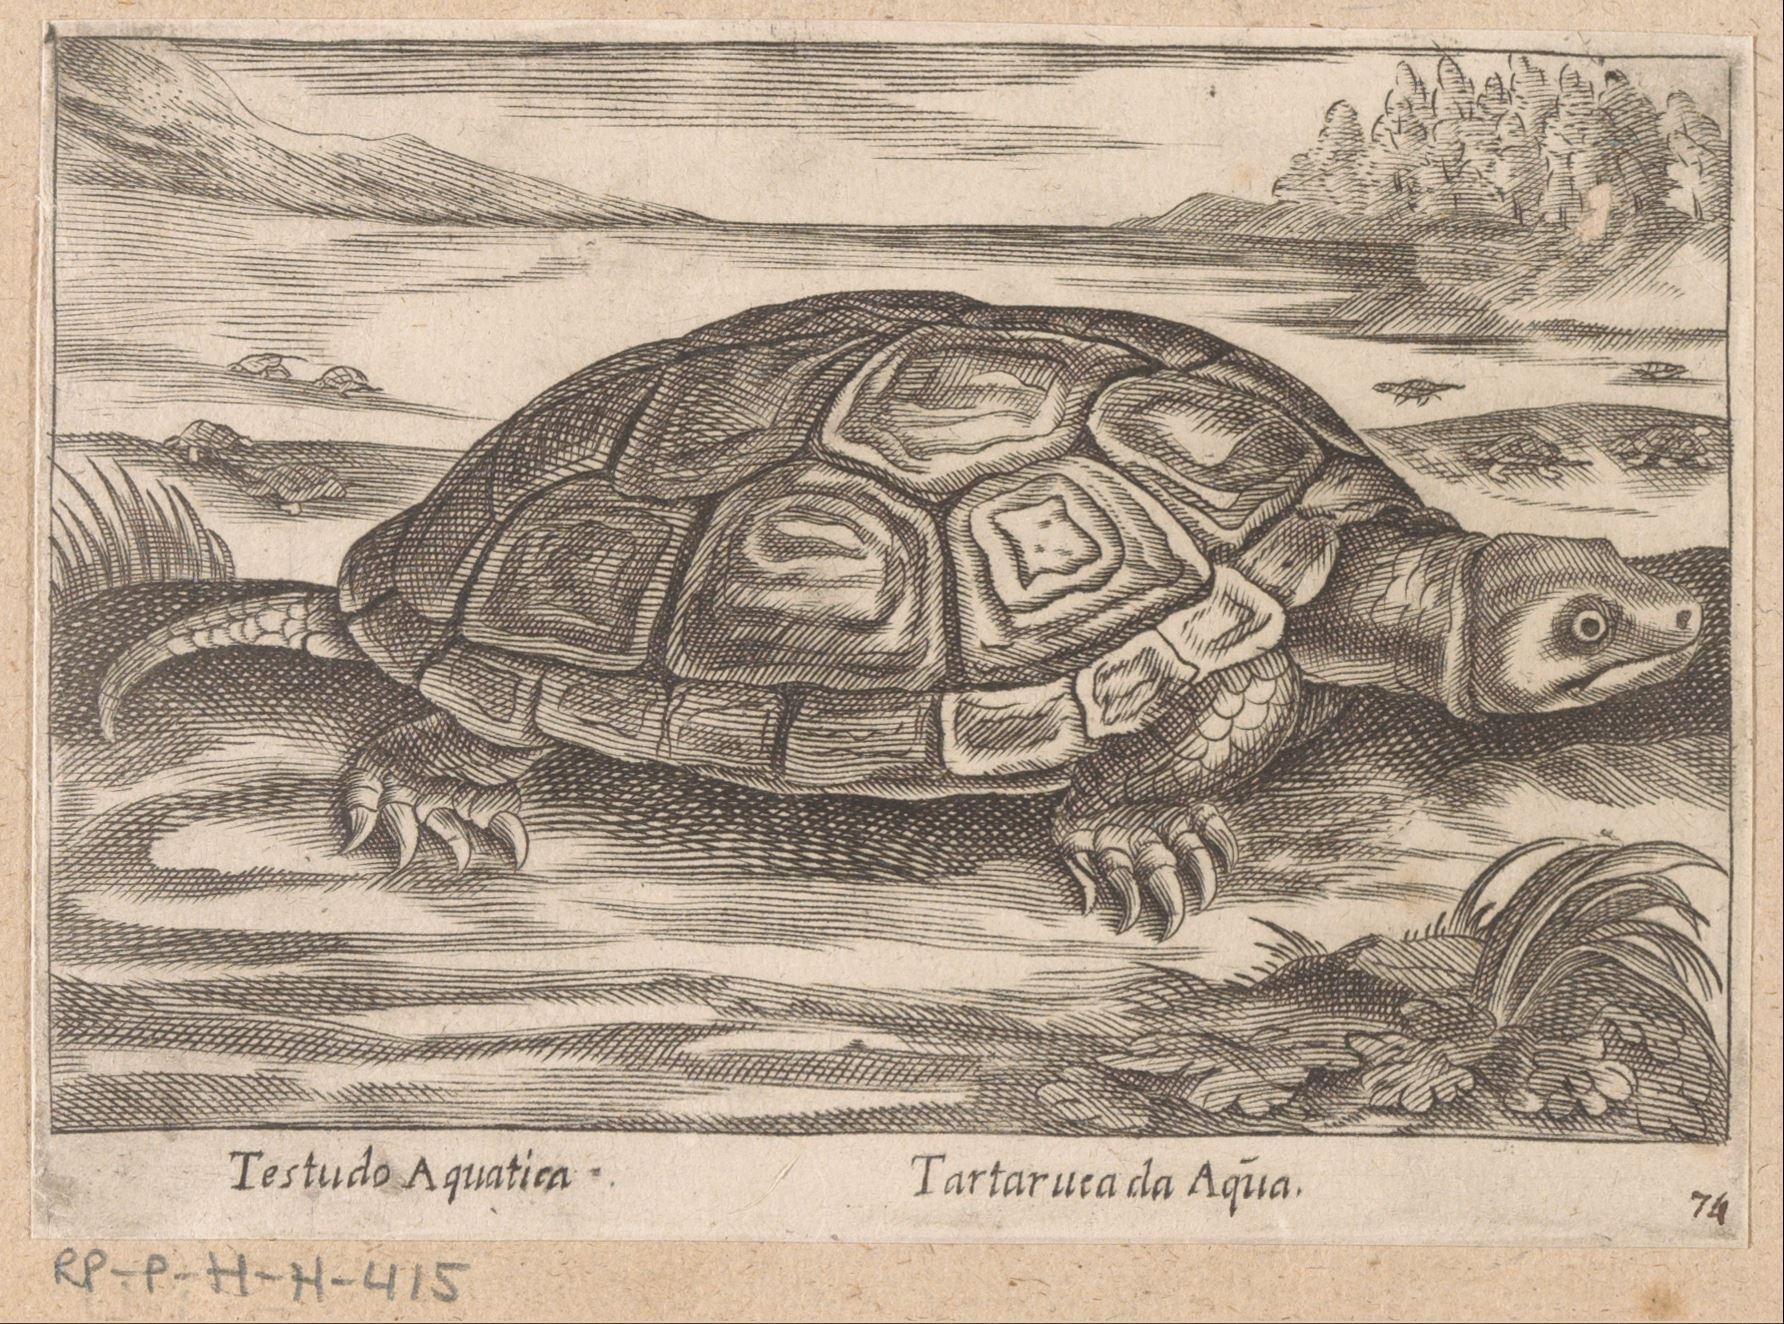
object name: print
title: Nova raccolta de li animali piu curiosi del mondo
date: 1565-1630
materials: paper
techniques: etching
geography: rome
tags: tortoises, turtles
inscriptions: number: ‘74’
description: Deze prent maakt deel uit van een reeks prenten van dieren door Antonio Tempesta. Bekend is dat een tweede staat (met nummering) van deze serie is uitgegeven door Giovanni Giacomo de' Rossi in 1650. Onbekend is wie de eerste staat heeft uitgegeven en wanneer.